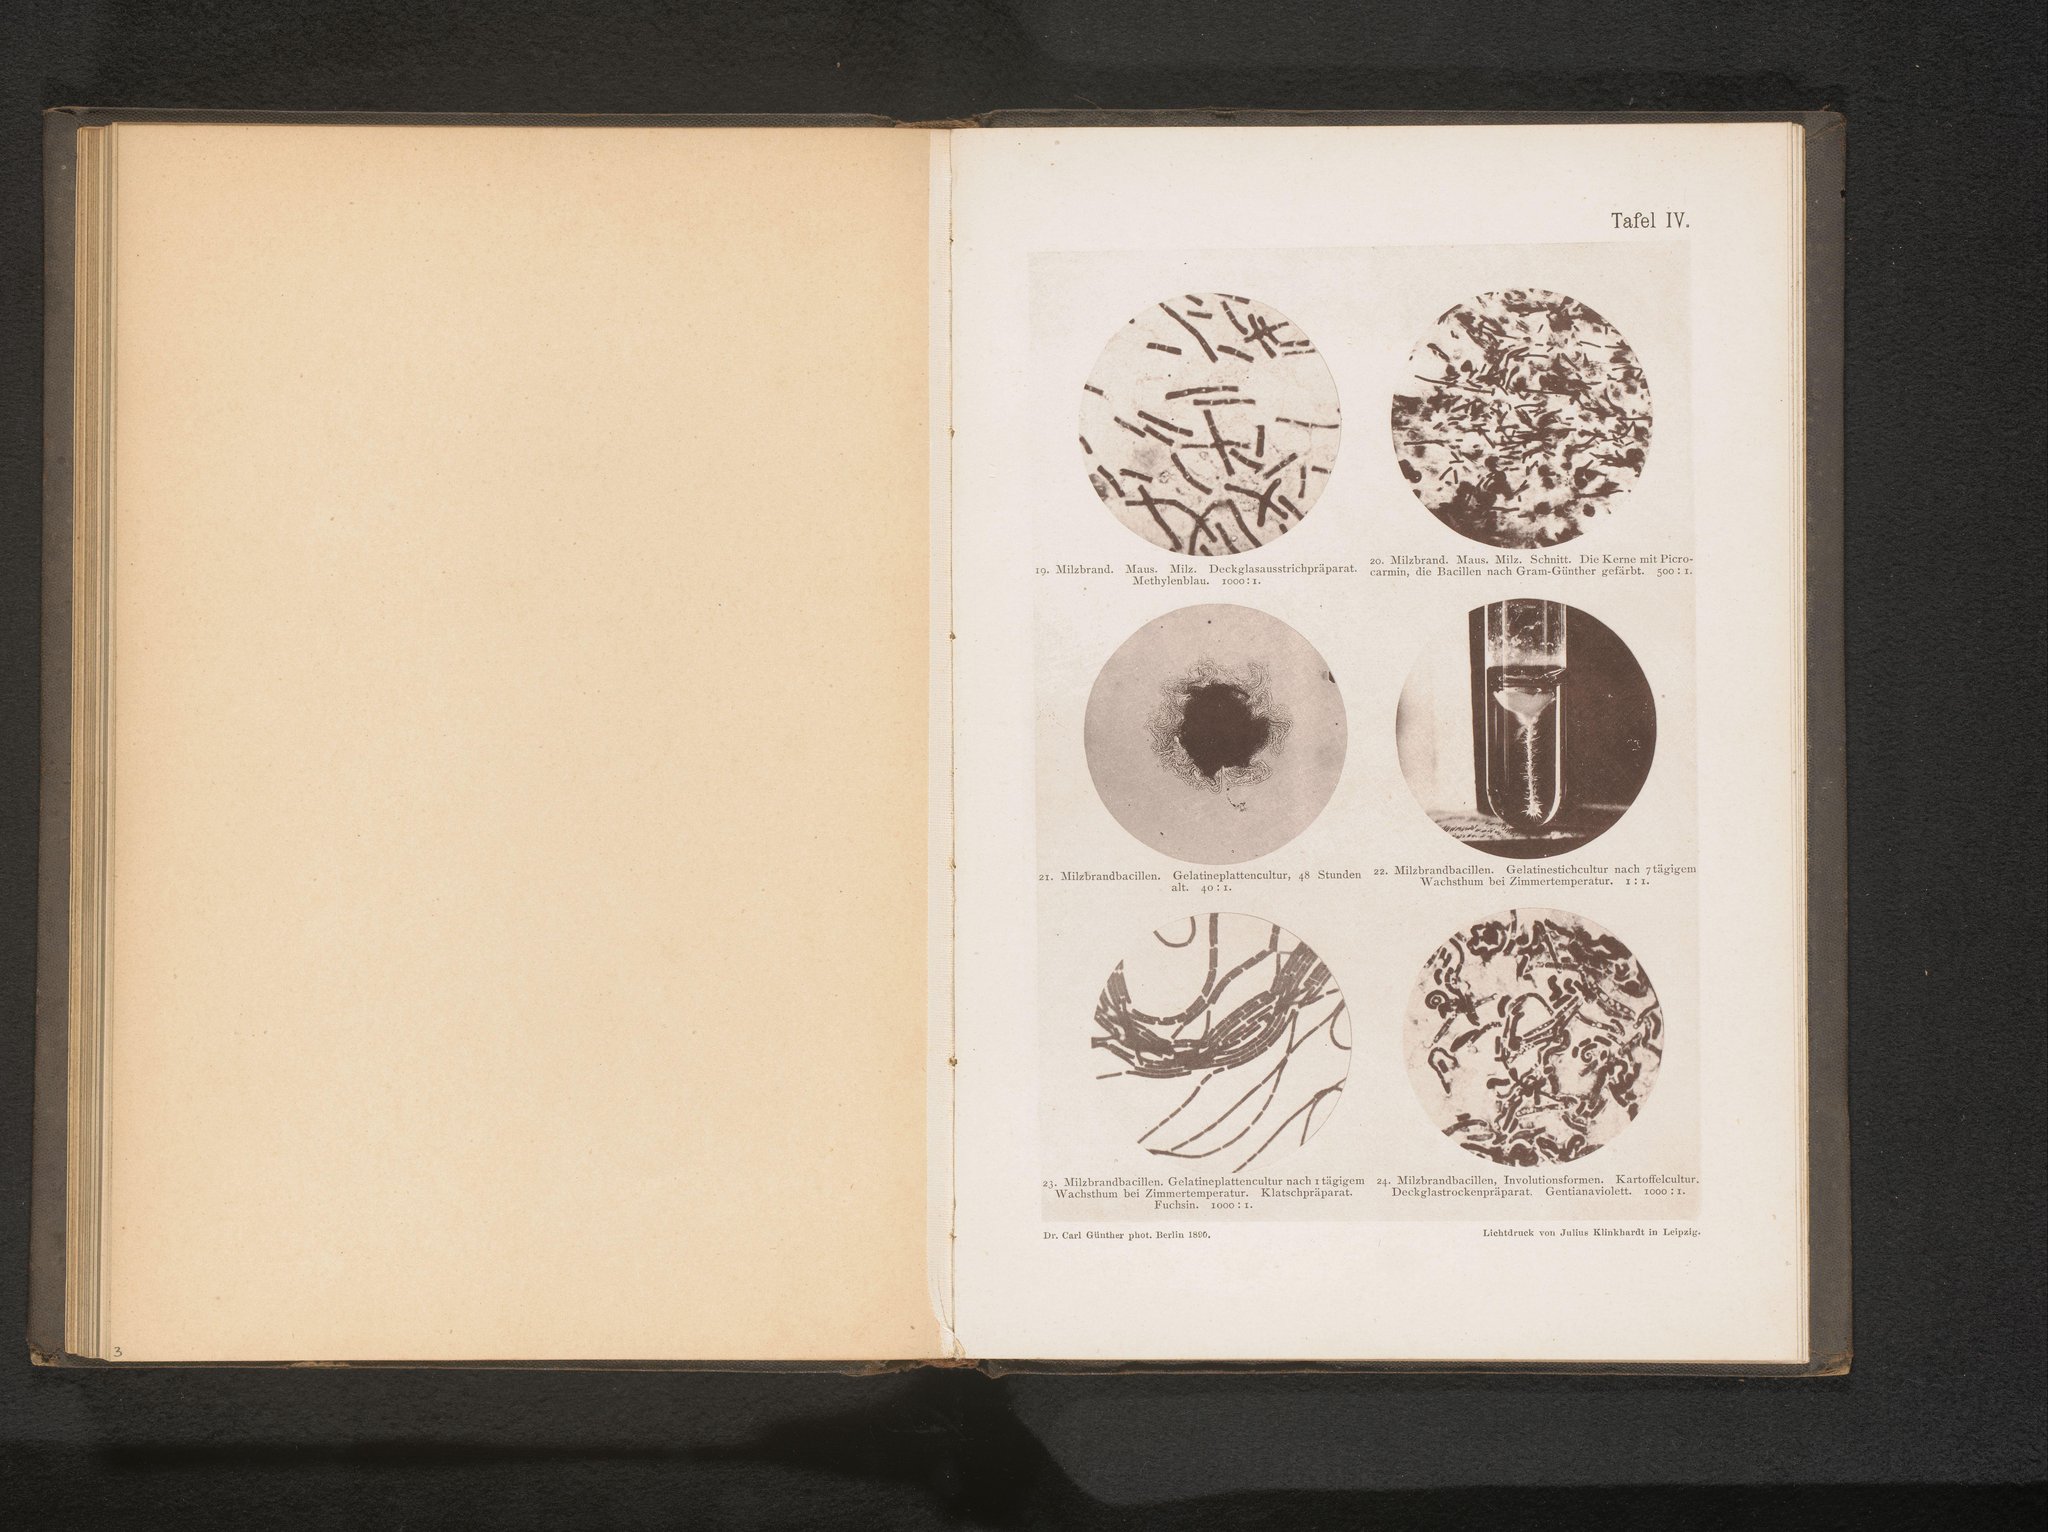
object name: page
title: Zes microscoopopnamen van de miltvuurbacterie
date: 1880-1890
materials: paper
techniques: photograph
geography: berlin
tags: unicellular animals, bacteria, bacilli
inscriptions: inscription: ‘19. Milzbrand. Maus. Milz. Deckglasausstrichpräparat. Methylenblau. 1000:1. 20. Milzbrand. Maus. Milz. Die Kerne mit Pocrocarmin, die Bacillen nach Gram-Günther gefärbt. 500:1. 21. Milzbrandbacillen. Gelatineplattencultur, 48 Stunden alt. 40:1. 22. Milzbrandbacillen. Gelatinestichcultur nach 7 tägigem Wachsthum bei Zimmertemepratur. 1:1. 23. Milzbrandbacillen. Gelatineplattencultur nach 1 tägigem Wachsthum bei Zimmertemperatur. Klatschpräparat. Fuchsin. 1000:1. 24. Milzbrandbacillen, Involutionsformen. Kartoffelcultur. Deckglastrockenpräparat. Gentianaviolett. 1000:1.’, number: ‘Tafel IV.’